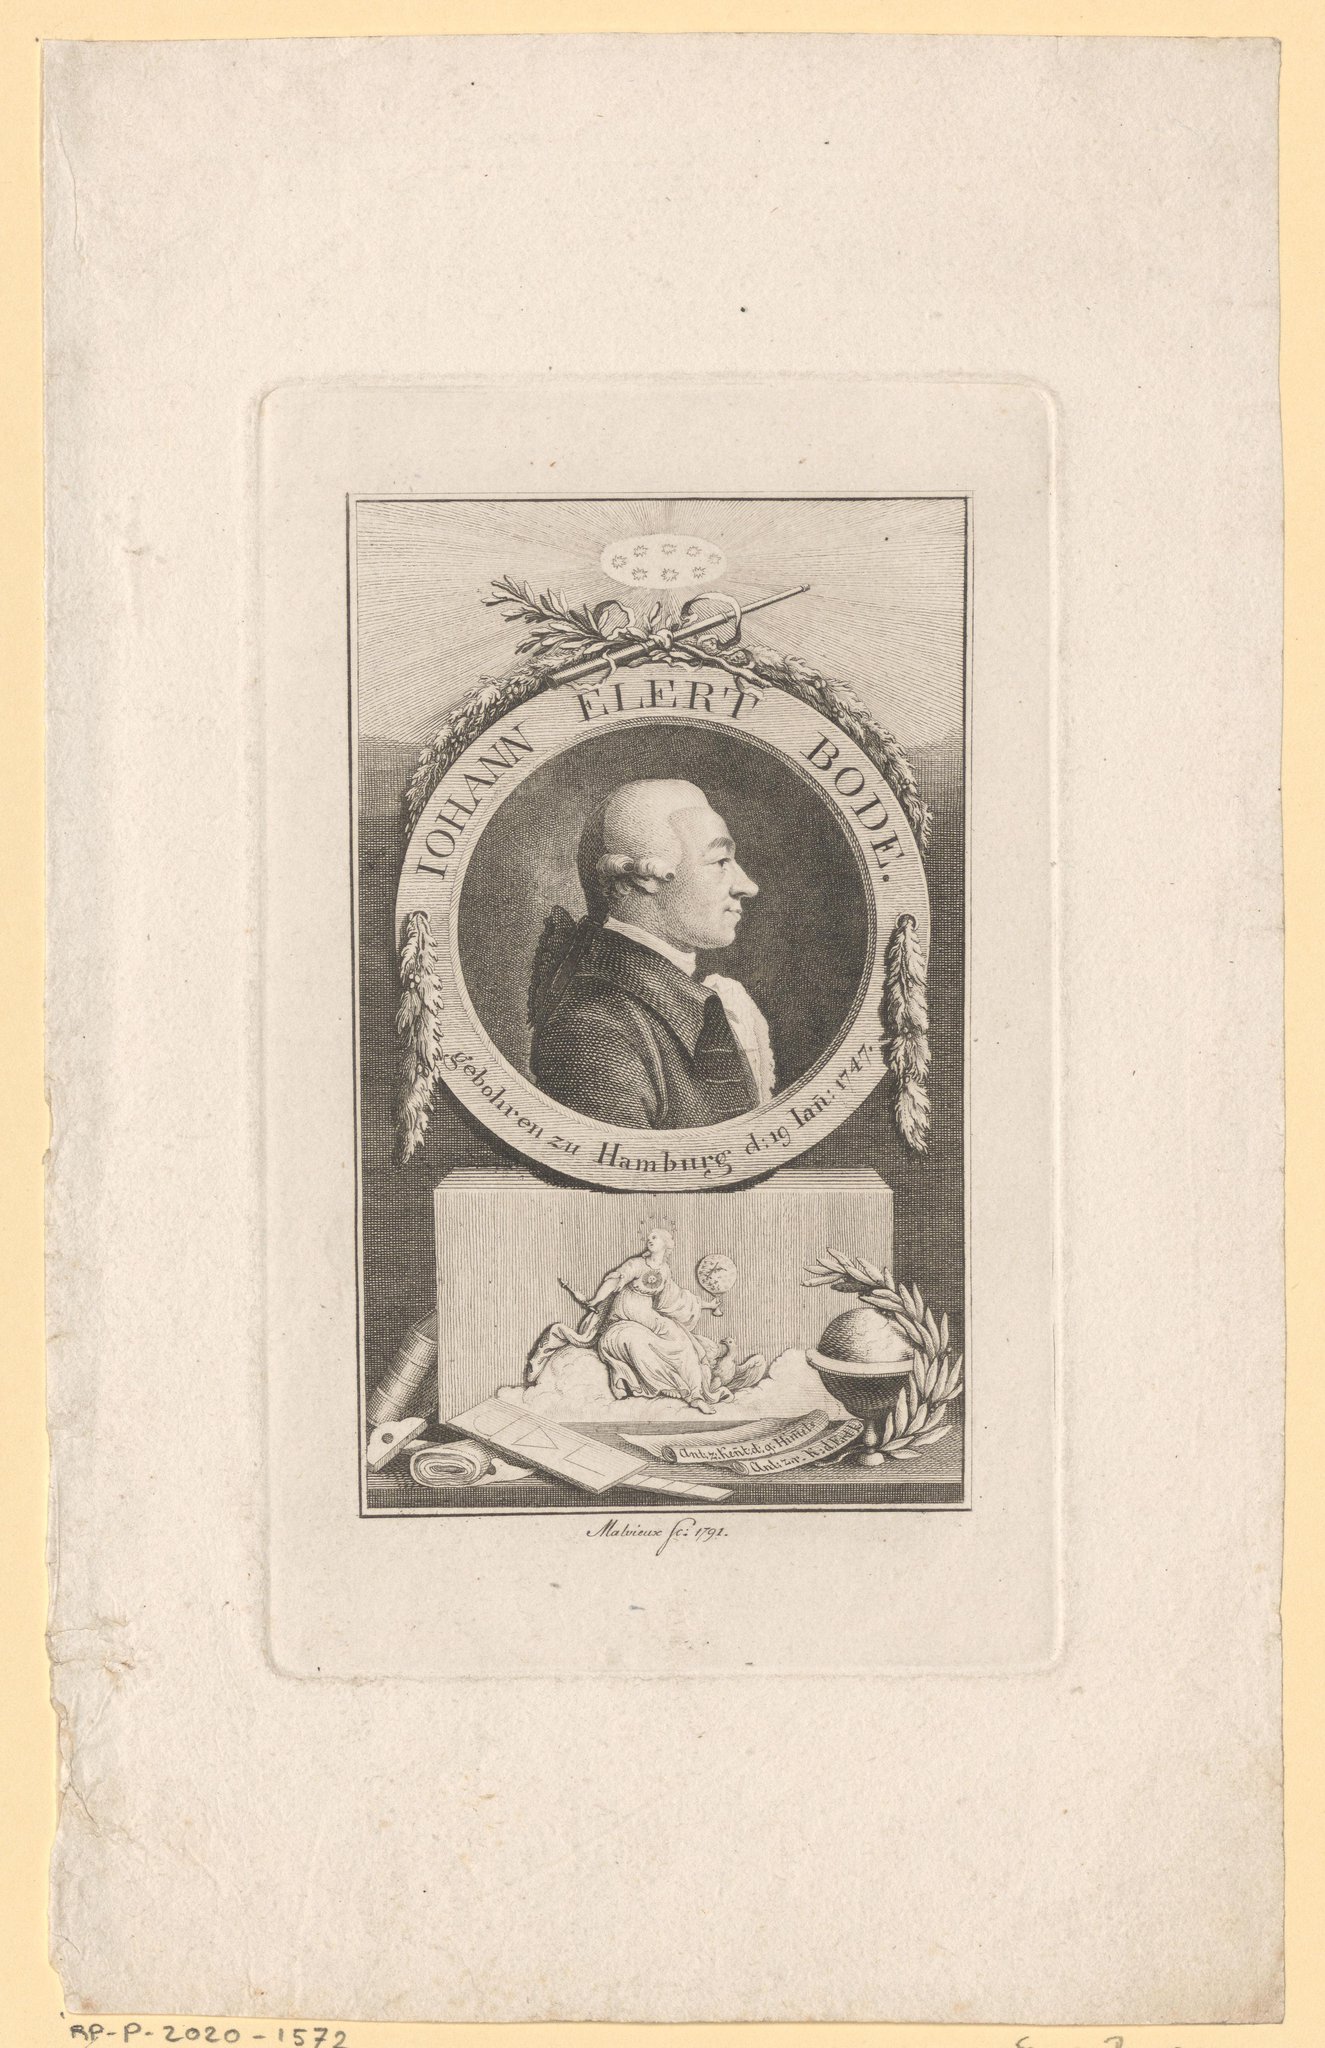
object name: print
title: Portret van Johann Elert Bode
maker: paul malvieux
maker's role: print maker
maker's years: 1763-1791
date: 1791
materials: paper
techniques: engraving, etching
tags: berlin, scholar, philosopher, historical persons, 'astronomia' (~ quadrivium); 'astronomia' (ripa)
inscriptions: date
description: Prent mogelijk uit: Bode, Johann Elert. Anleitung zur Kenntniss des gestirnten Himmels. Berlijn: Christian Friedrich Himburg, 1792.